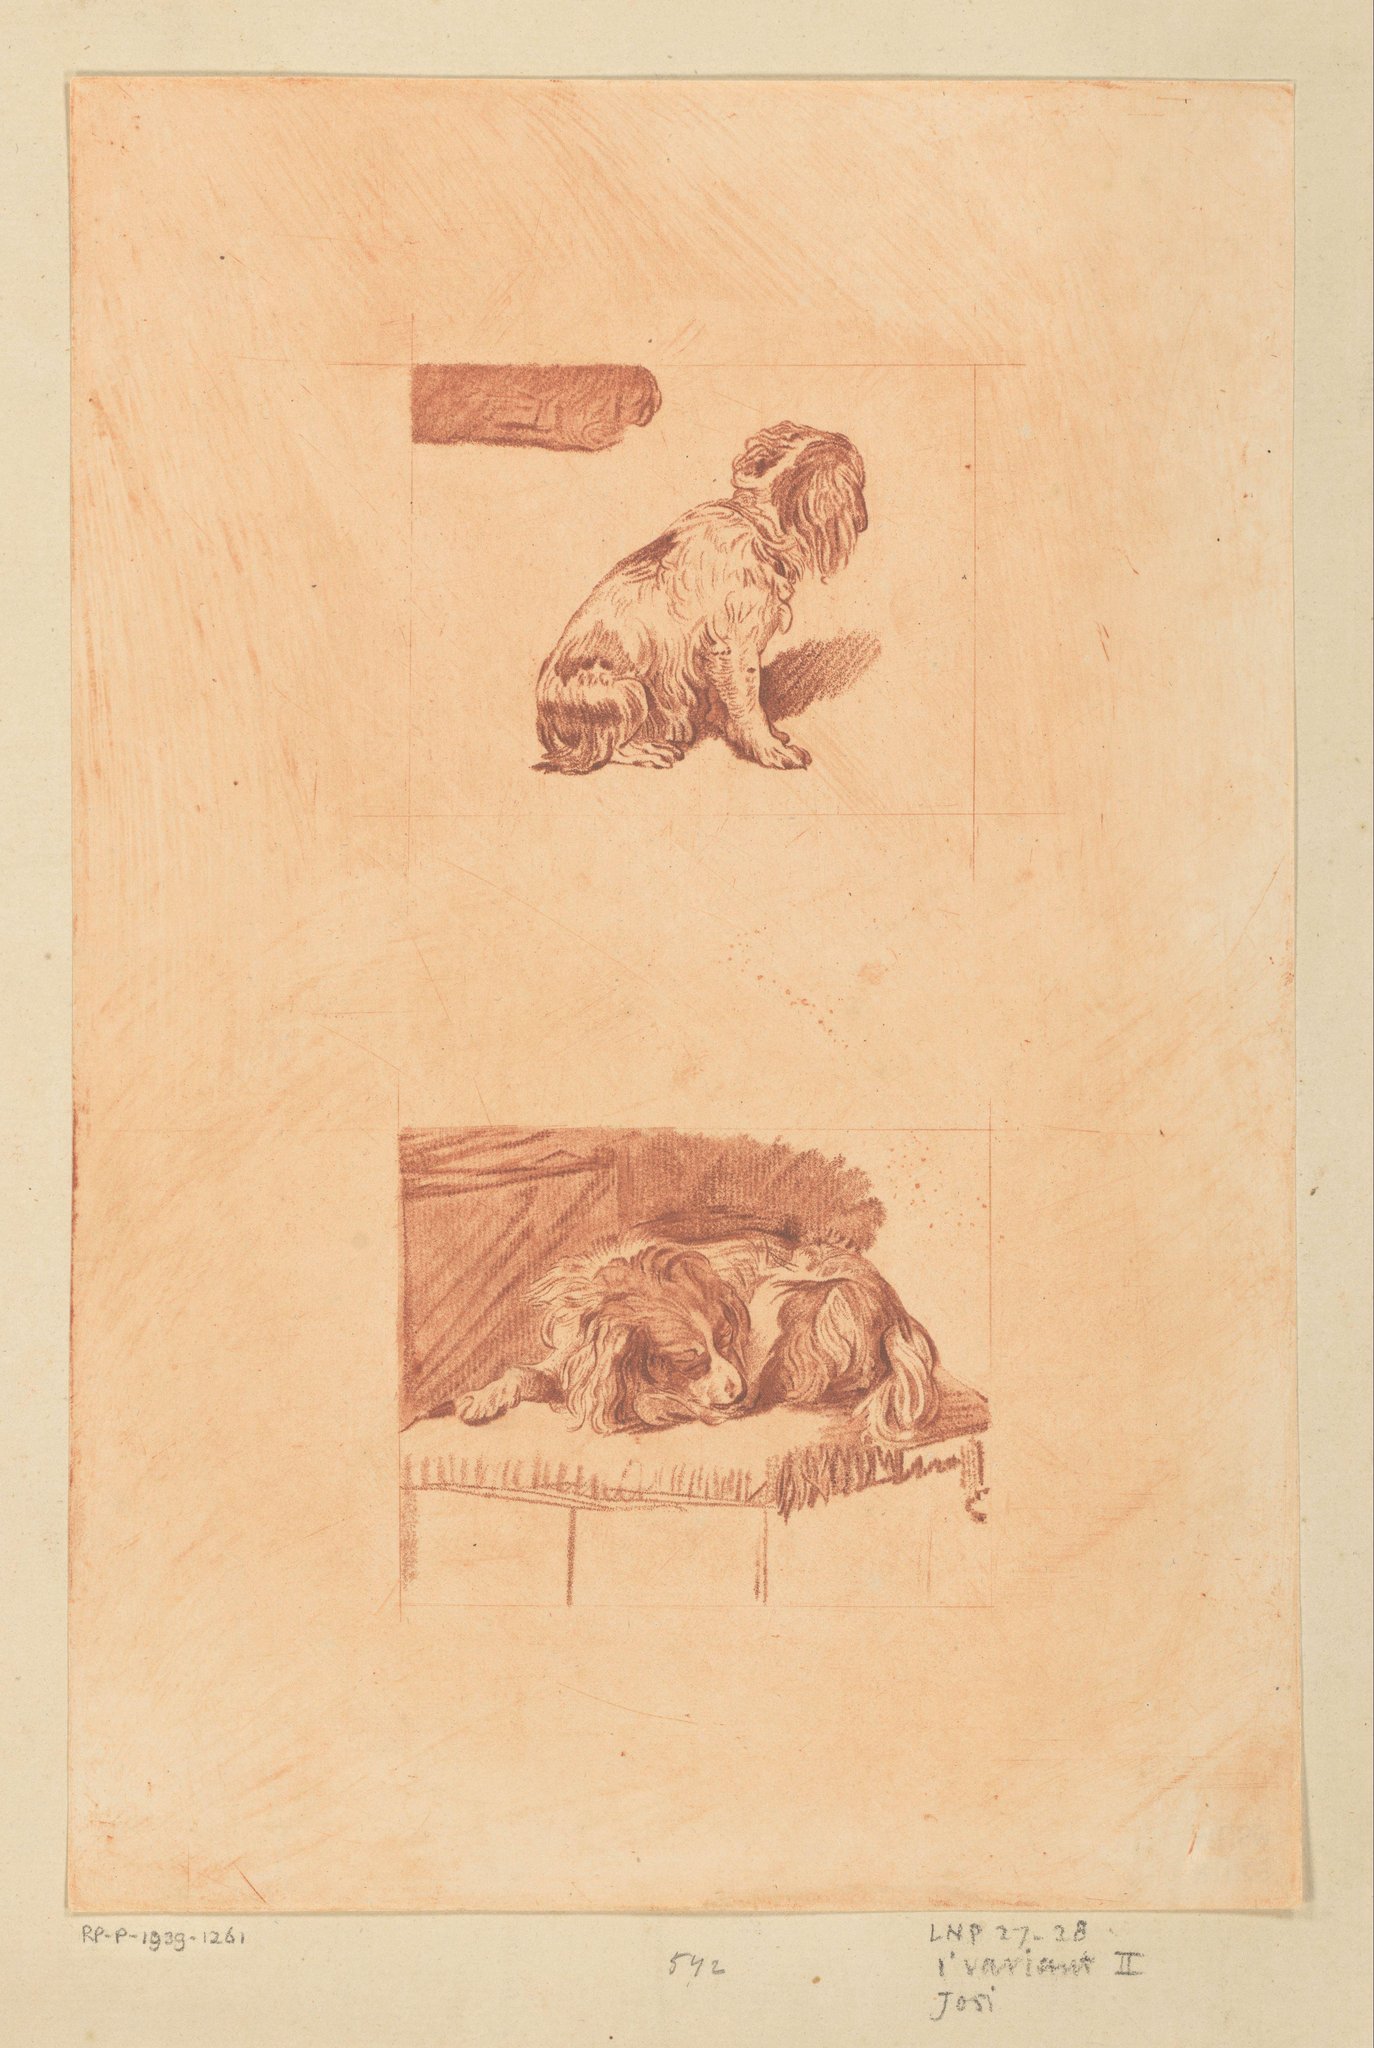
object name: print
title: Zittende en liggende hond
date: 1777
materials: paper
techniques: printmaking, etching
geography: amsterdam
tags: dog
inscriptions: collector's mark: ‘RIJKS / MUSM’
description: Twee voorstellingen op een blad. Boven een zittende hond. Onder een liggende hond. De prent ligt los in een album, zie blad 28.